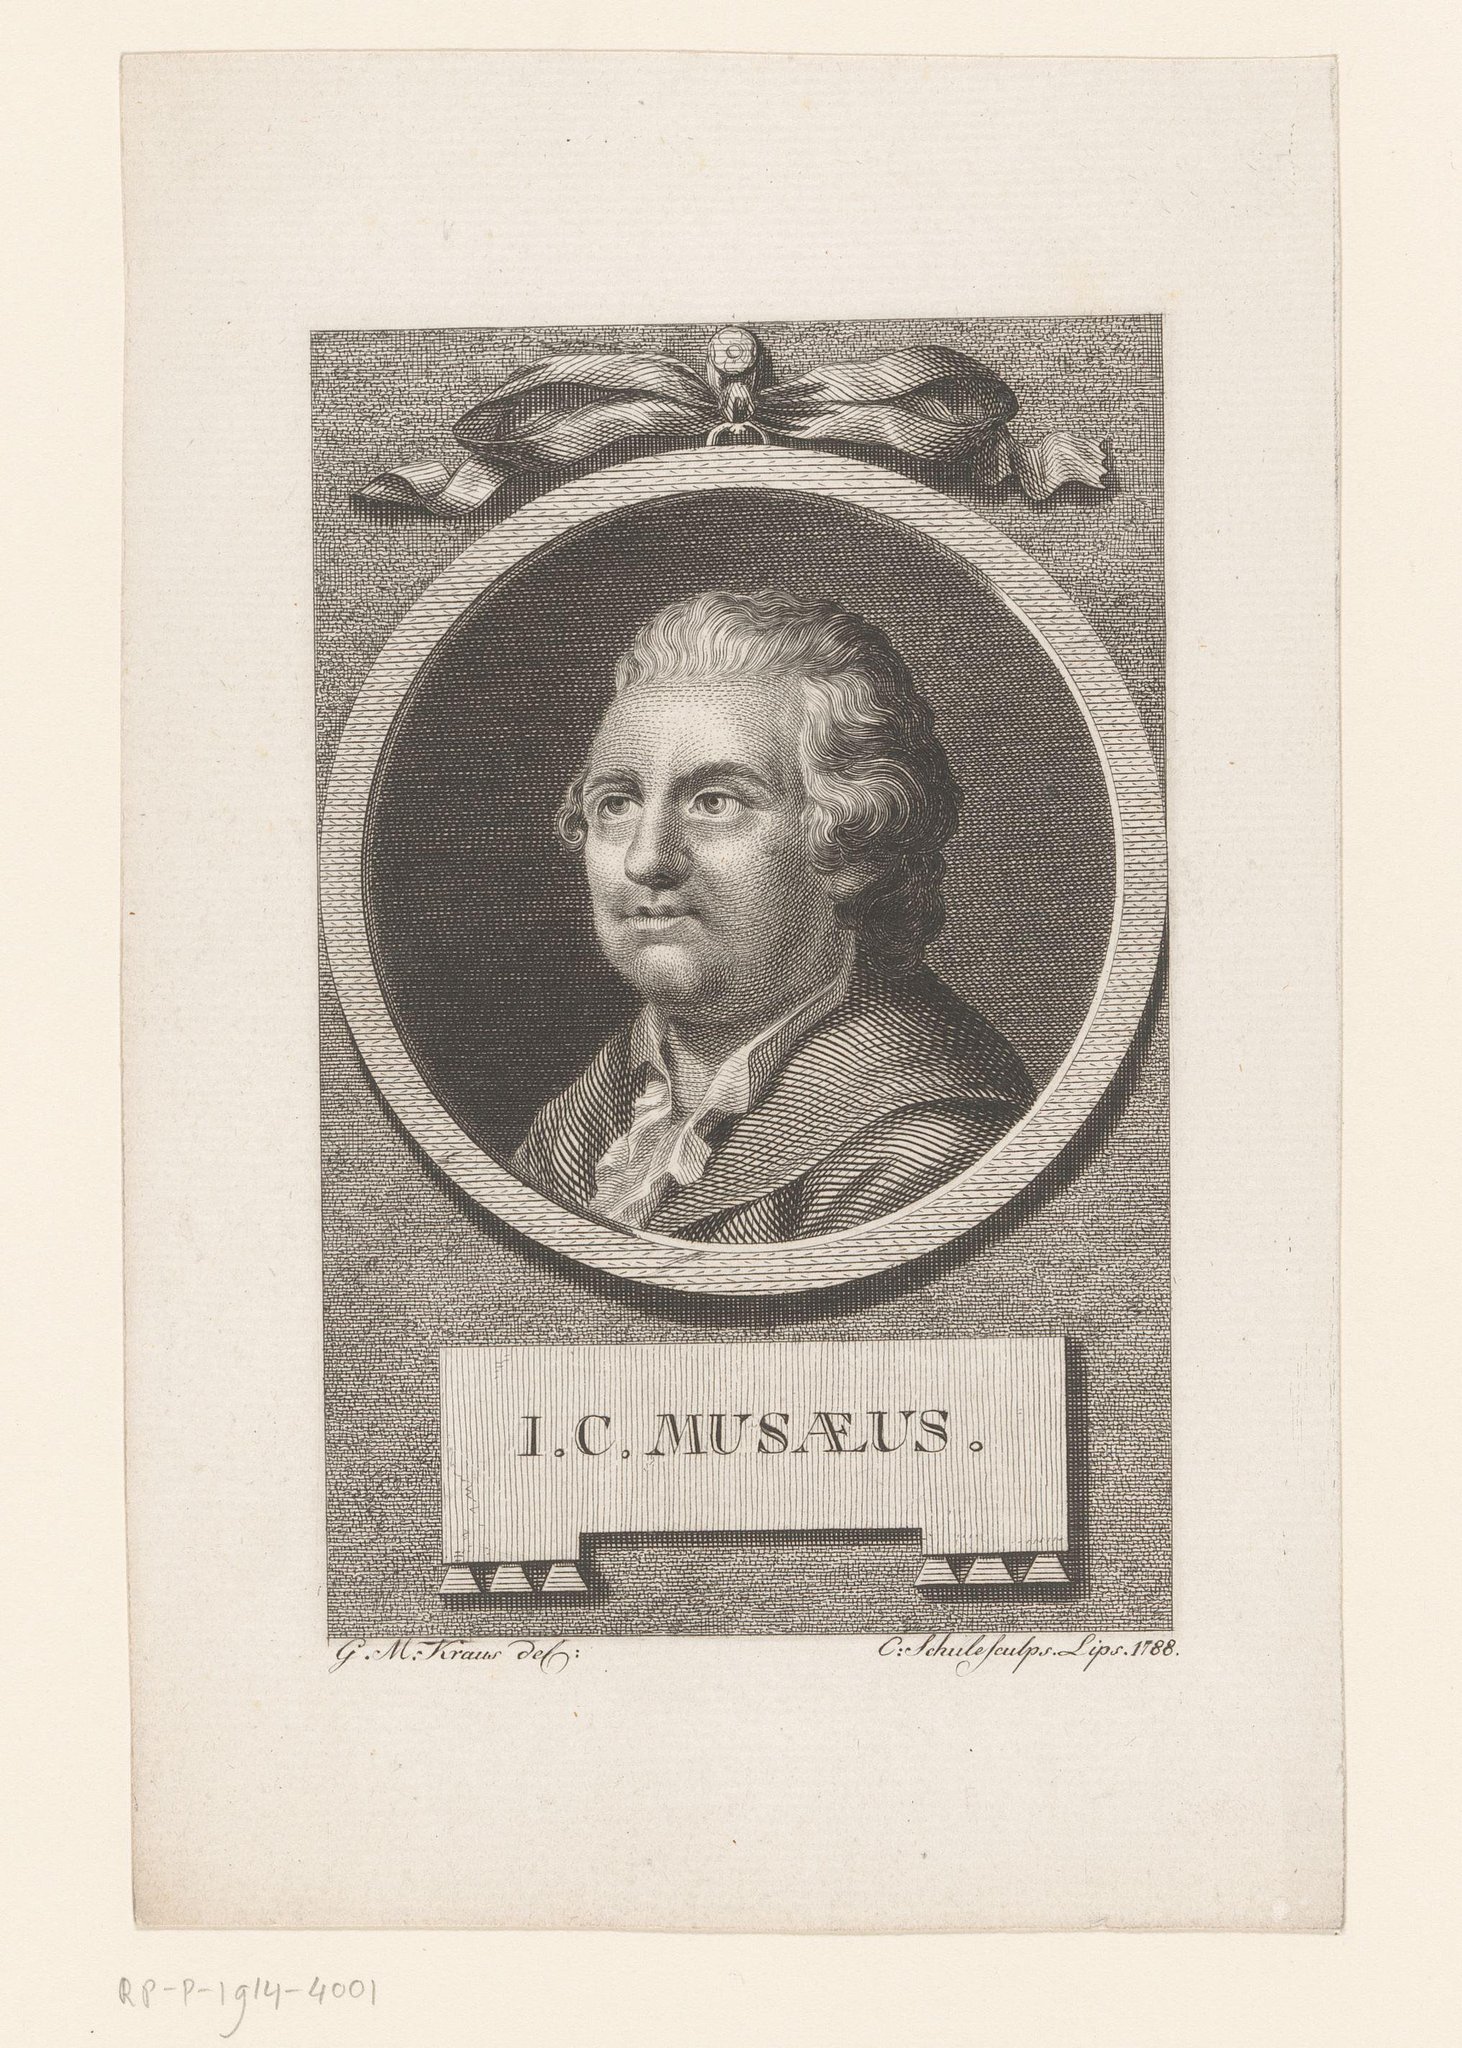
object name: print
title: J.C. Musaeus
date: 1788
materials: paper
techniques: engraving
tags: historical persons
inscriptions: collector's mark: Lugt 2228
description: Portret van Johann Karl August Musäus, Duits filoloog, schrijver en verzamelaar van Duitse volksverhalen.